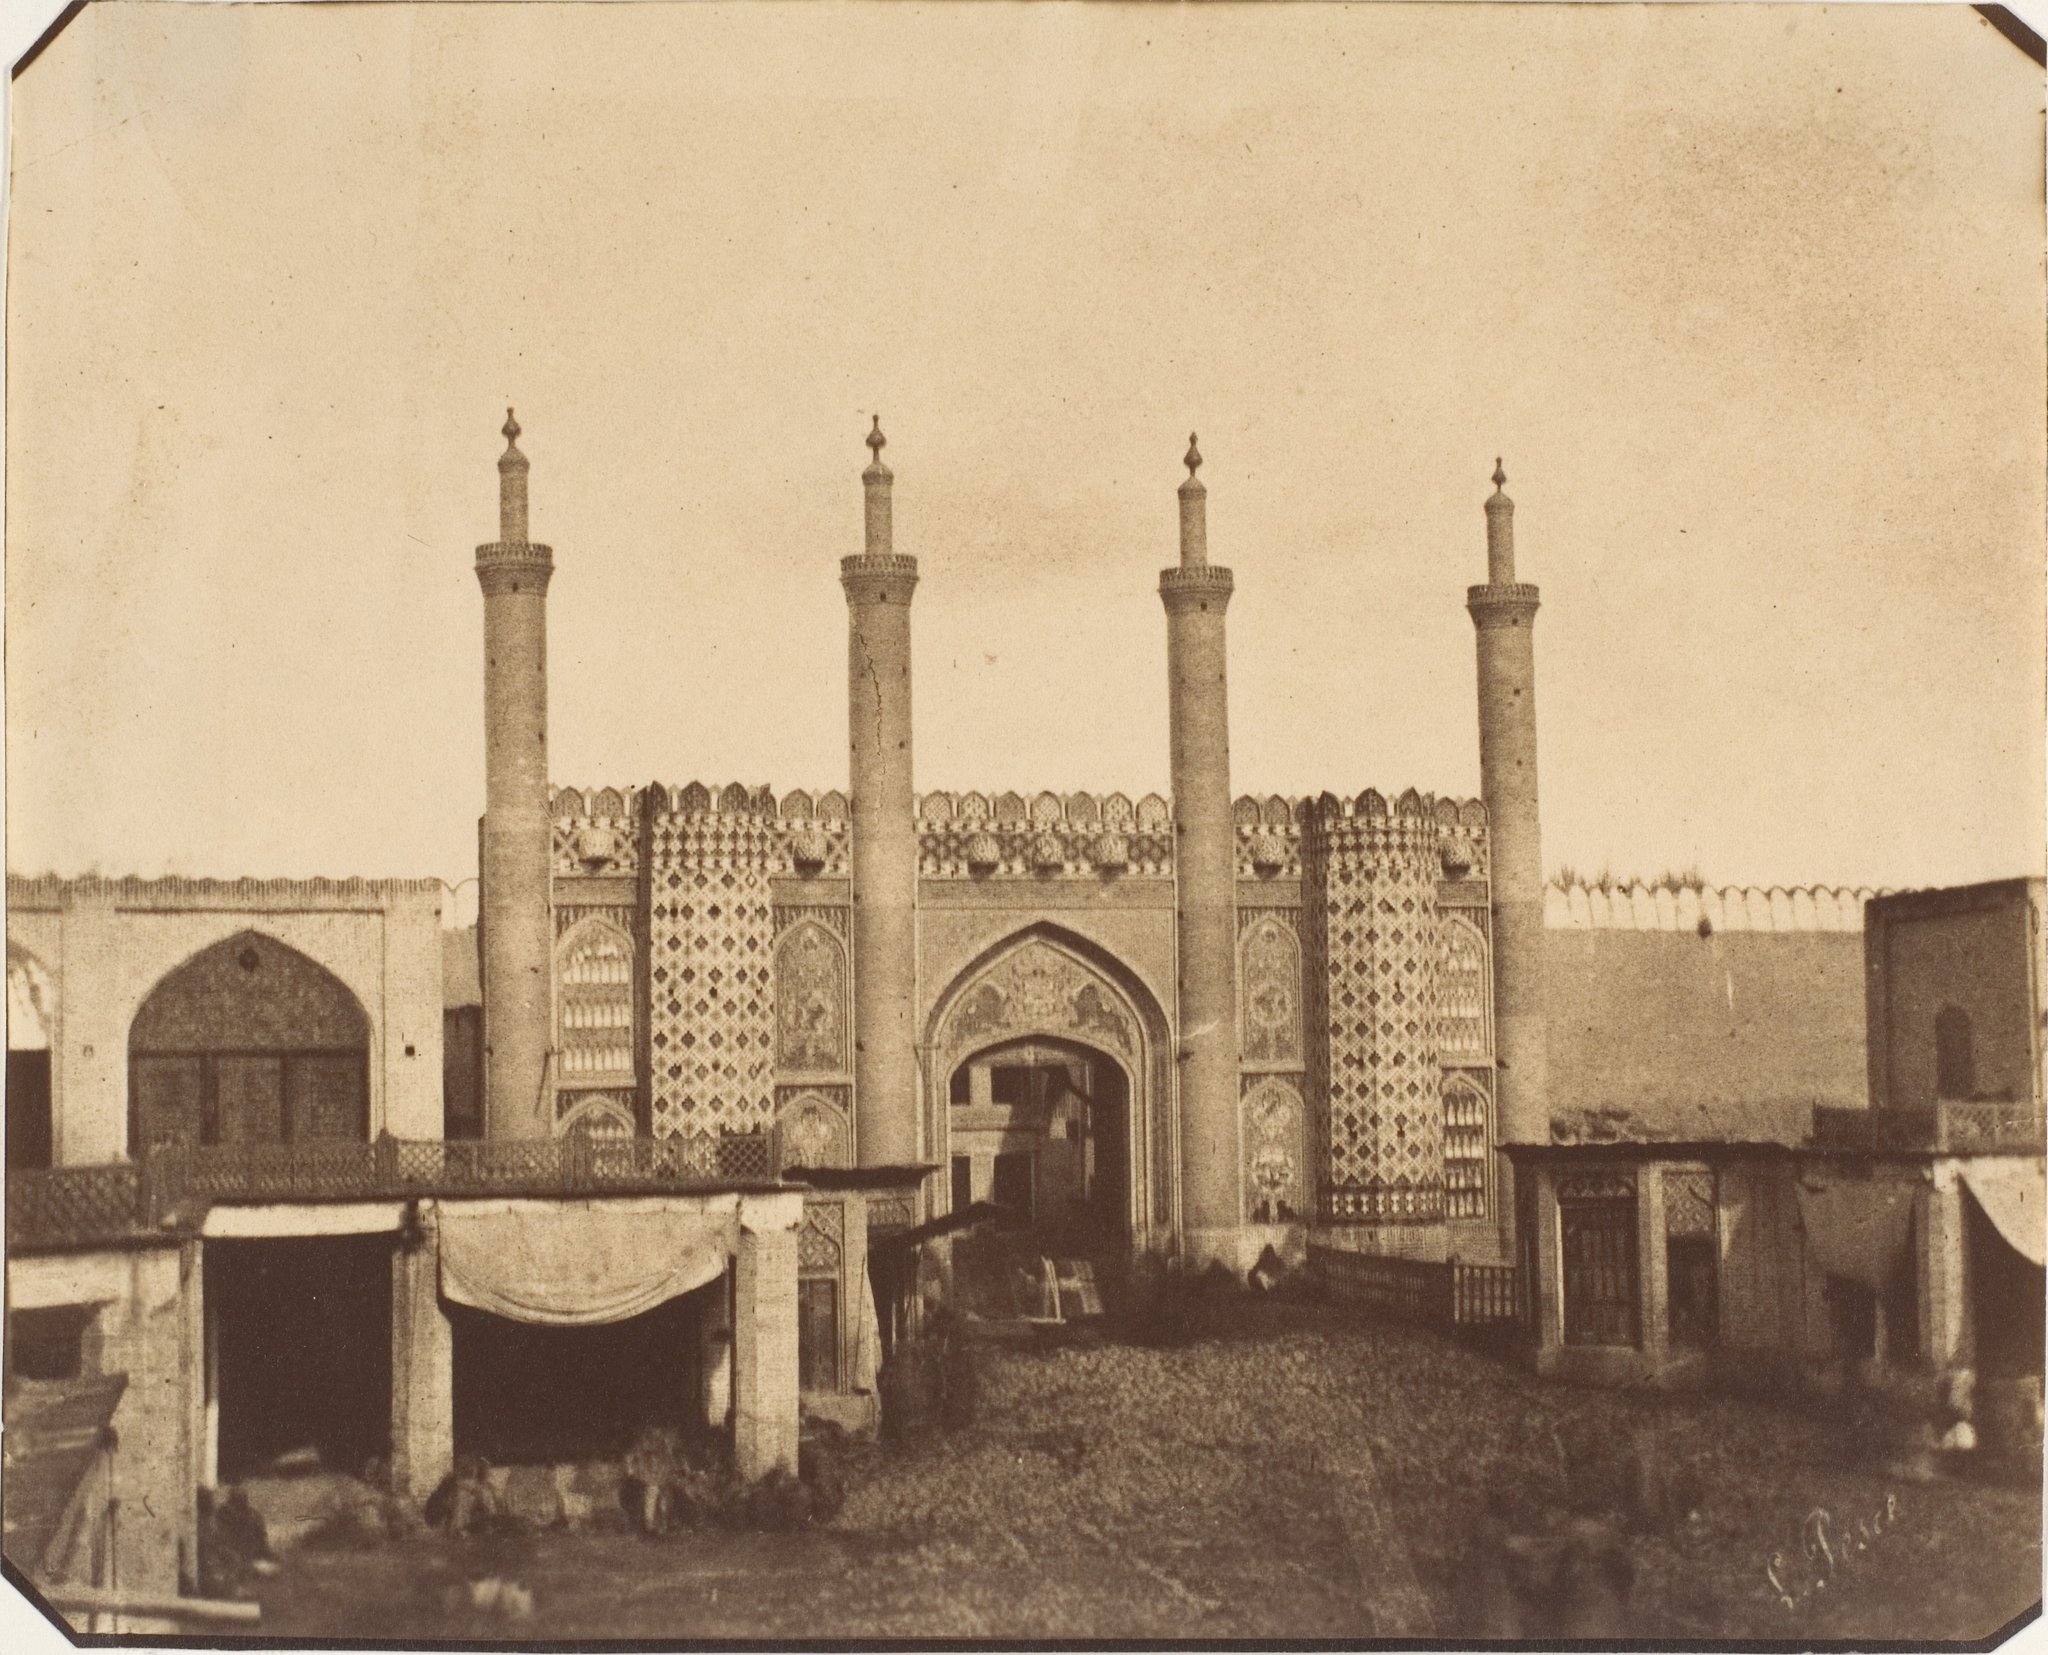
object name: photograph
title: [The New Gate, Teheran]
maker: luigi pesce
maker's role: artist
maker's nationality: italian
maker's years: 1818-1891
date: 1850-1859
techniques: albumen silver print, paper negative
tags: architecture,columns,gates